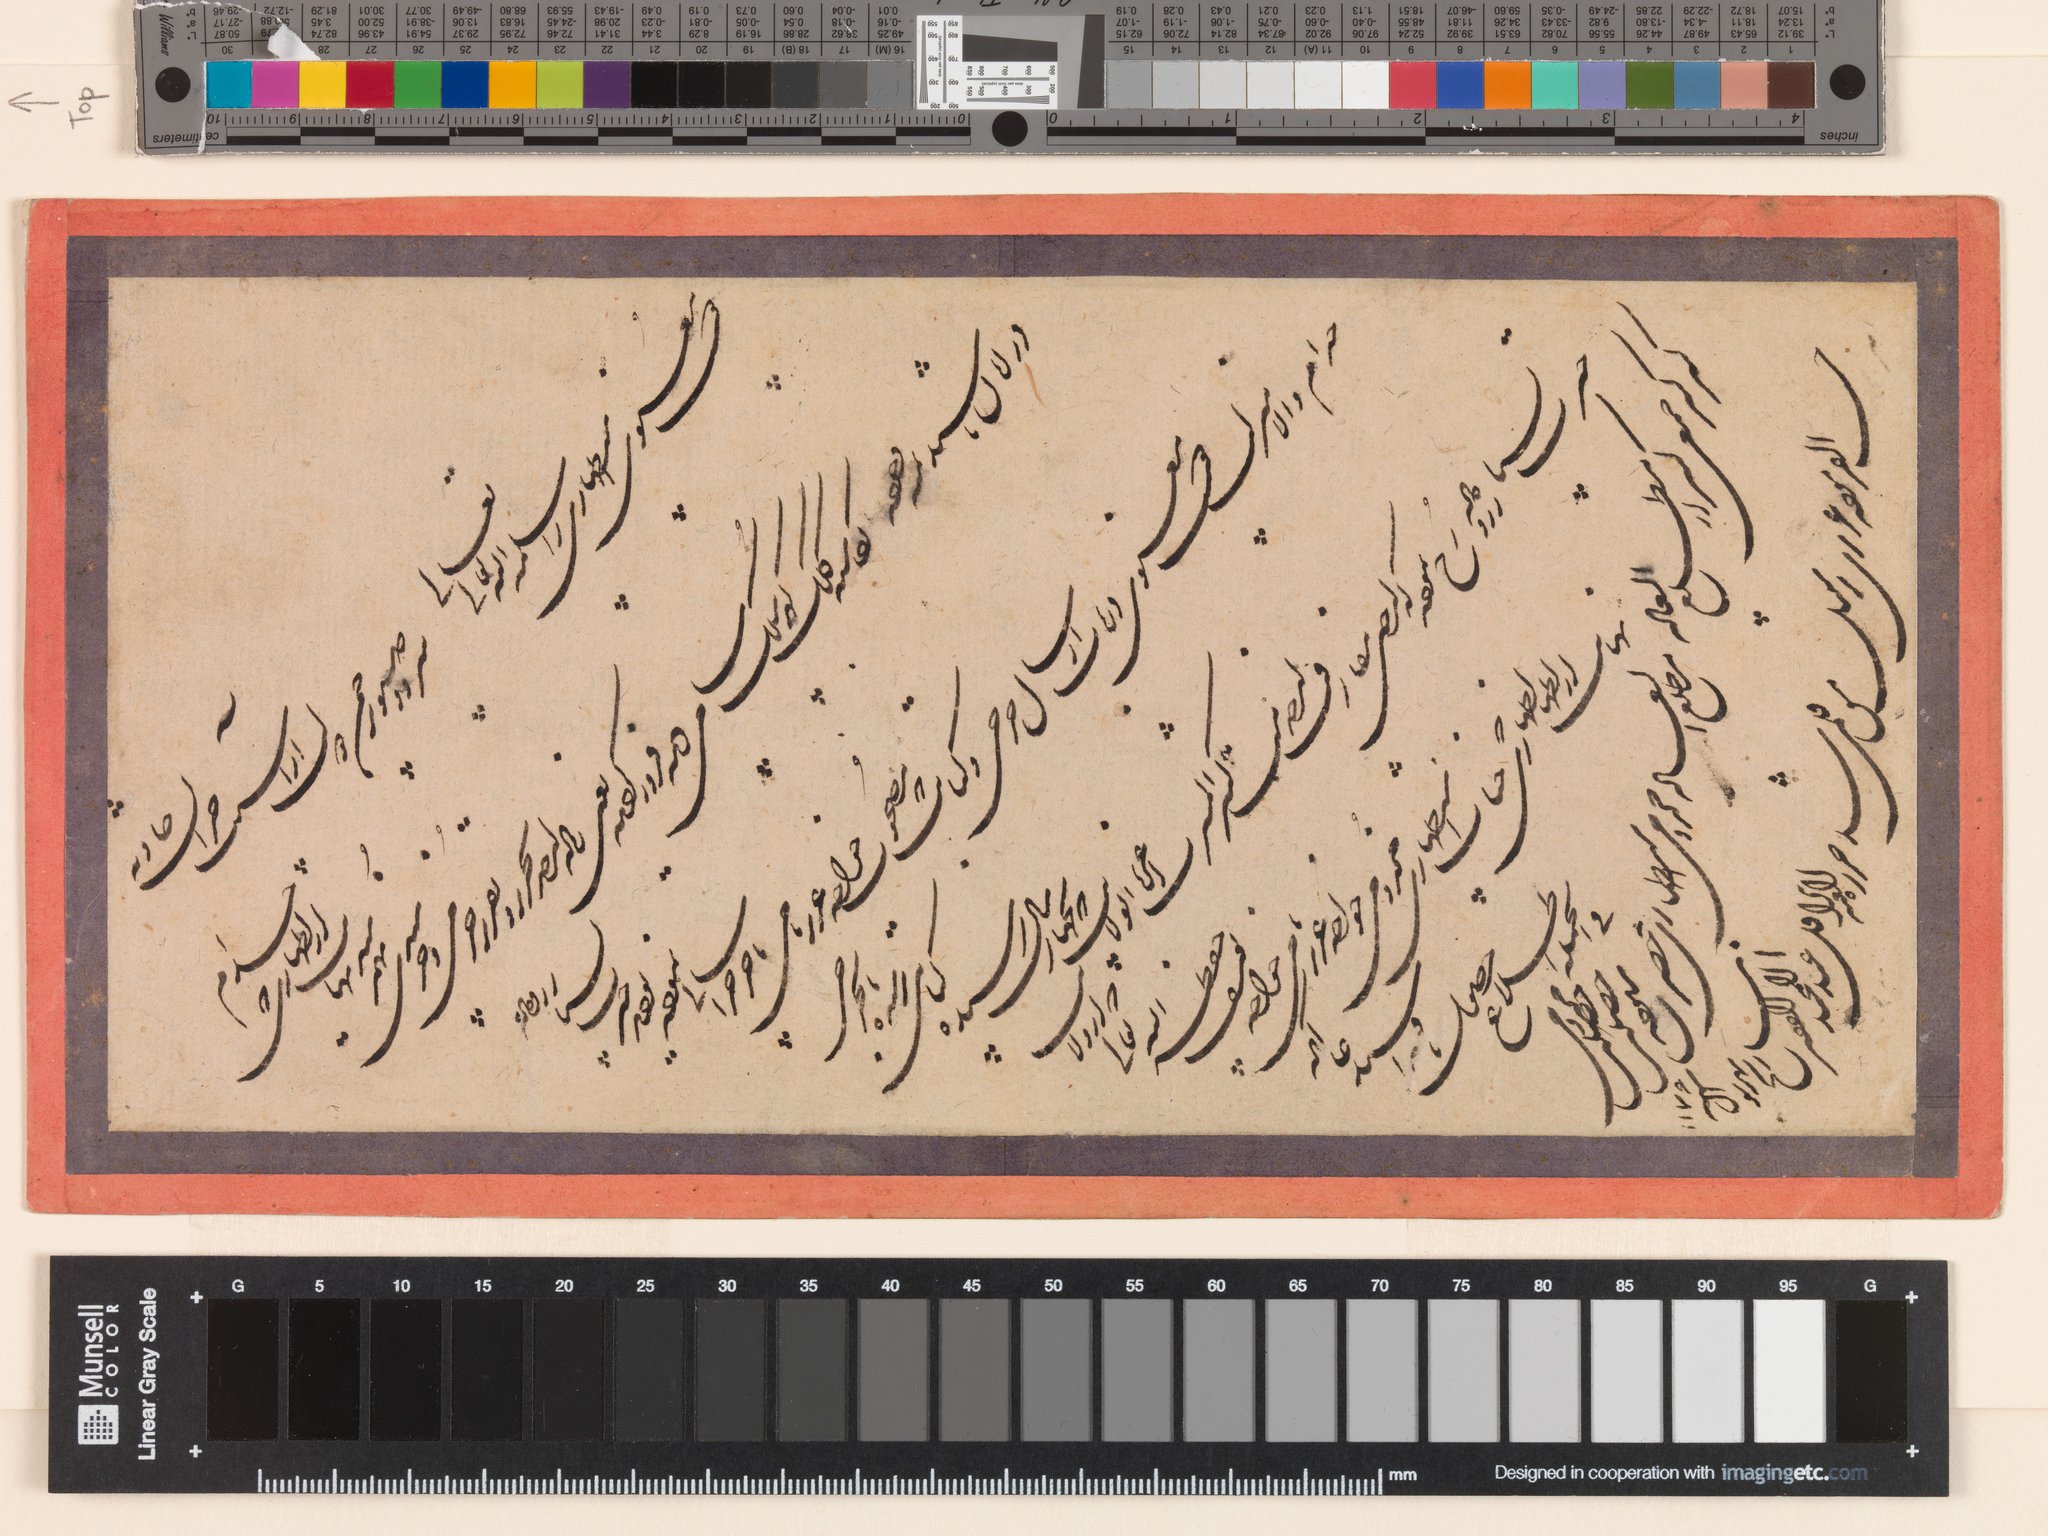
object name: non illustrated single work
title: Page of Calligraphy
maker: abd al-majid taleqani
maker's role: calligrapher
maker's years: 1712-1796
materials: gold, ink, paper, watercolor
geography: iran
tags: arabic,calligraphy